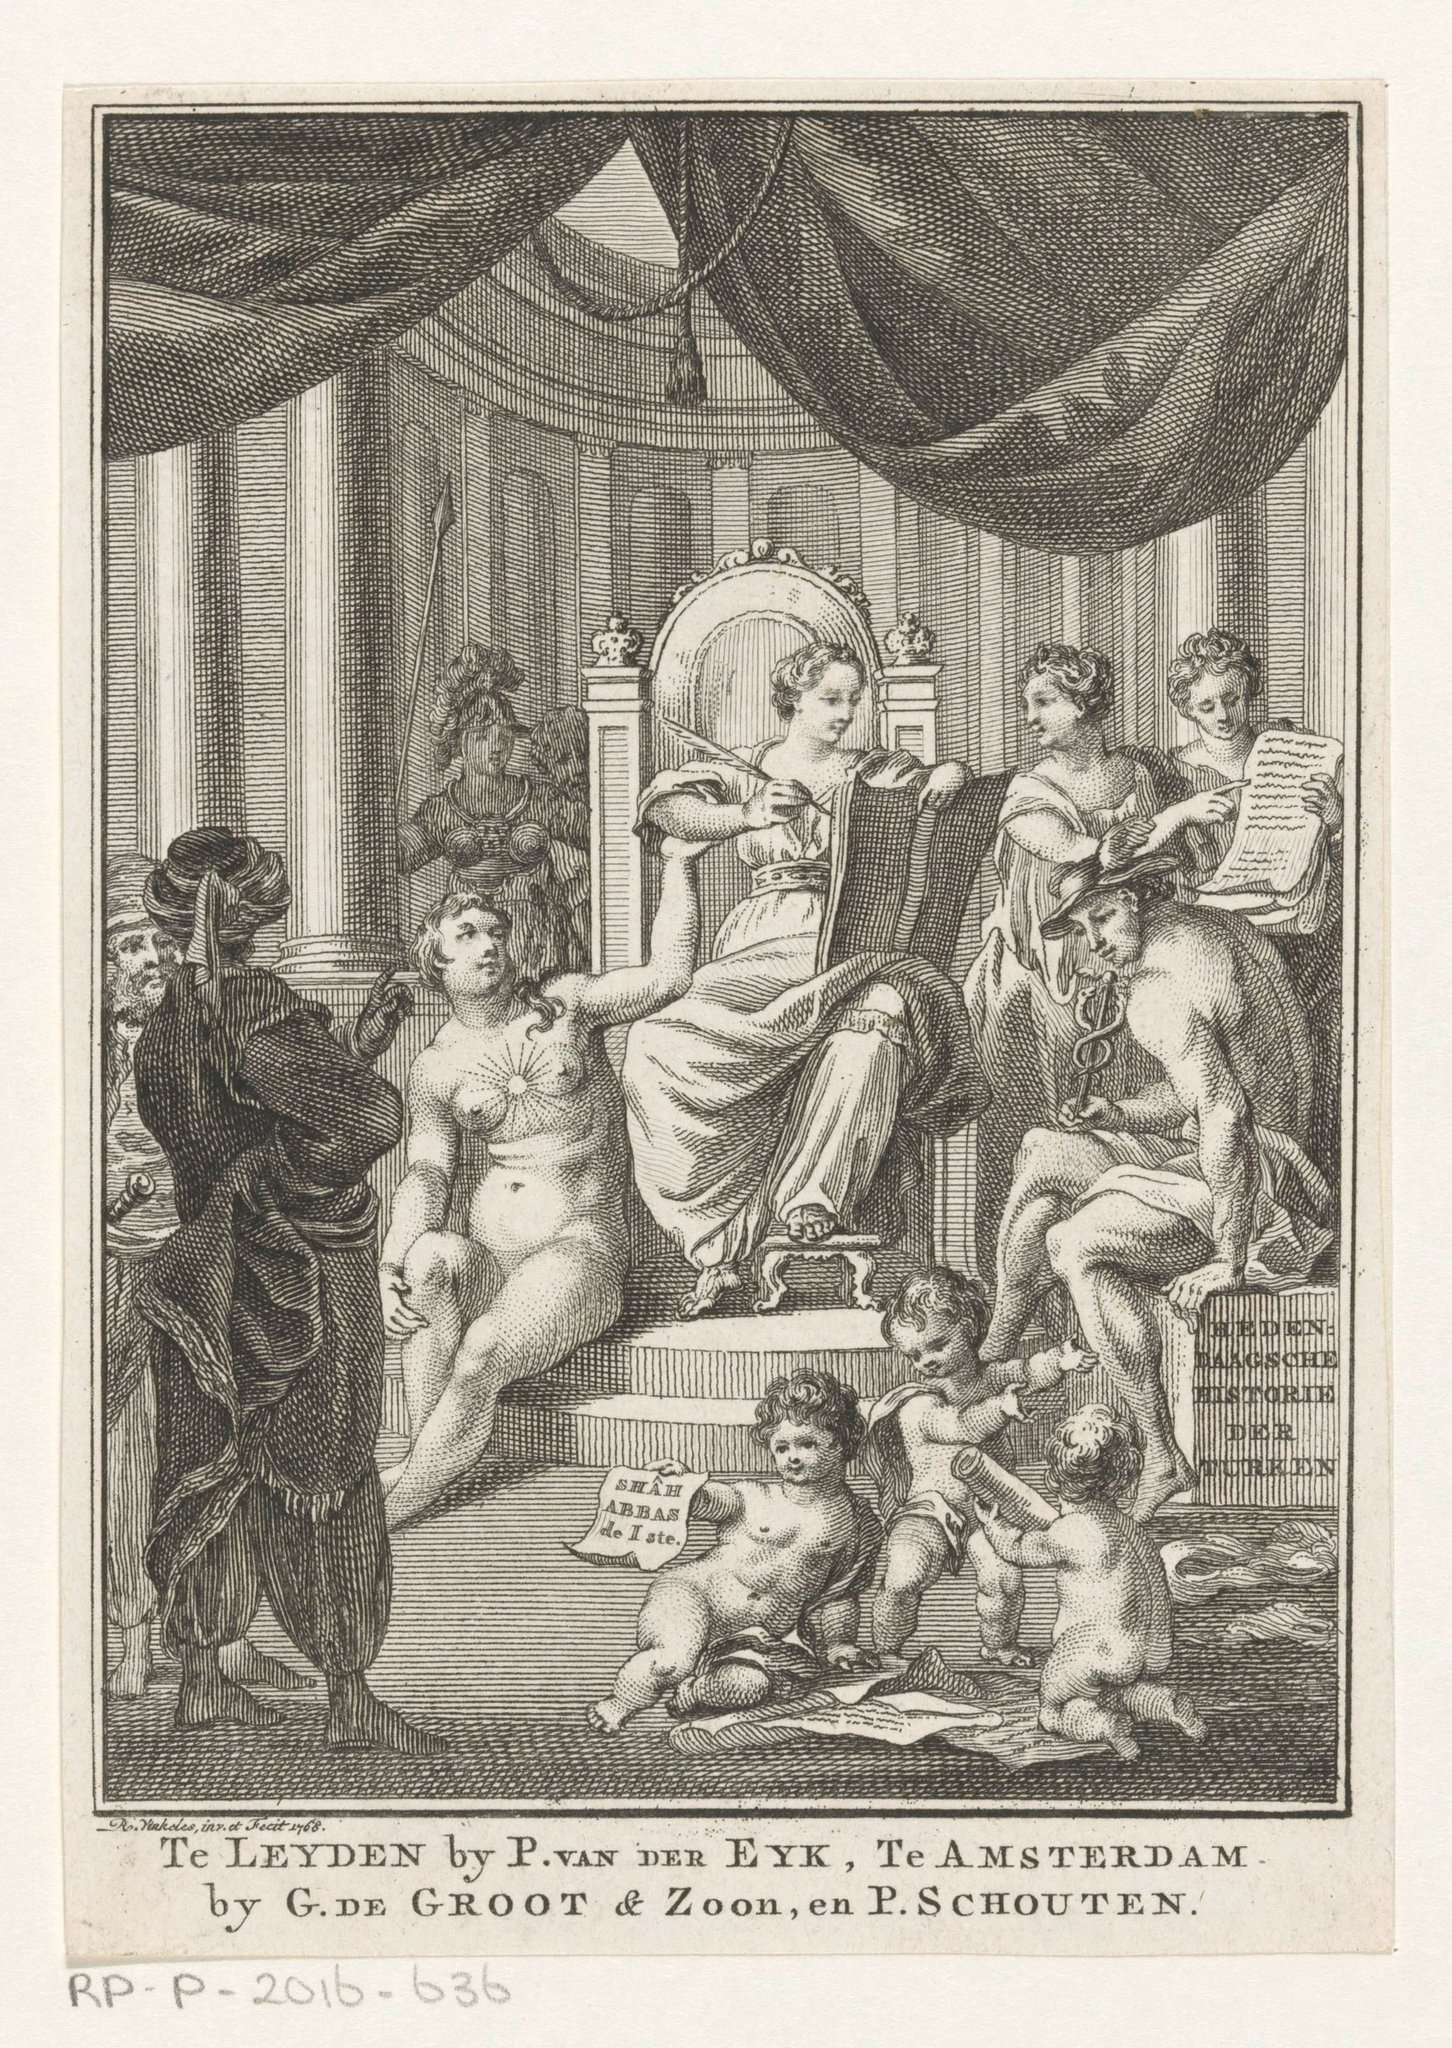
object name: titelblad, titelpagina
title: Titelpagina voor: S.n., Hedendaagsche historie of Het vervolg van de Algemeene historie, 1767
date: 1767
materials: paper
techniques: engraving, etching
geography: amsterdam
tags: prudence, 'prudentia'; 'prudenza' (ripa) ~ one of the four cardinal virtues, truth; 'verità' (ripa), 'historia'; 'historia' (ripa), classical mythology and ancient history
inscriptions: collector's mark: Lugt 2228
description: Titelpagina voor: S.n. Hedendaagsche historie of Het vervolg van de Algemeene historie (...) Vde Deel. Amsterdam: Amsterdam: Groot en Zoon, Gerrit de en Schouten, Petrus, Leiden: Eyk, Pieter van der, 1767. Prent afkomstig uit een plakalbum met titelprenten, ornamenten etc. op blauw papier in 1983 uit elkaar gehaald.